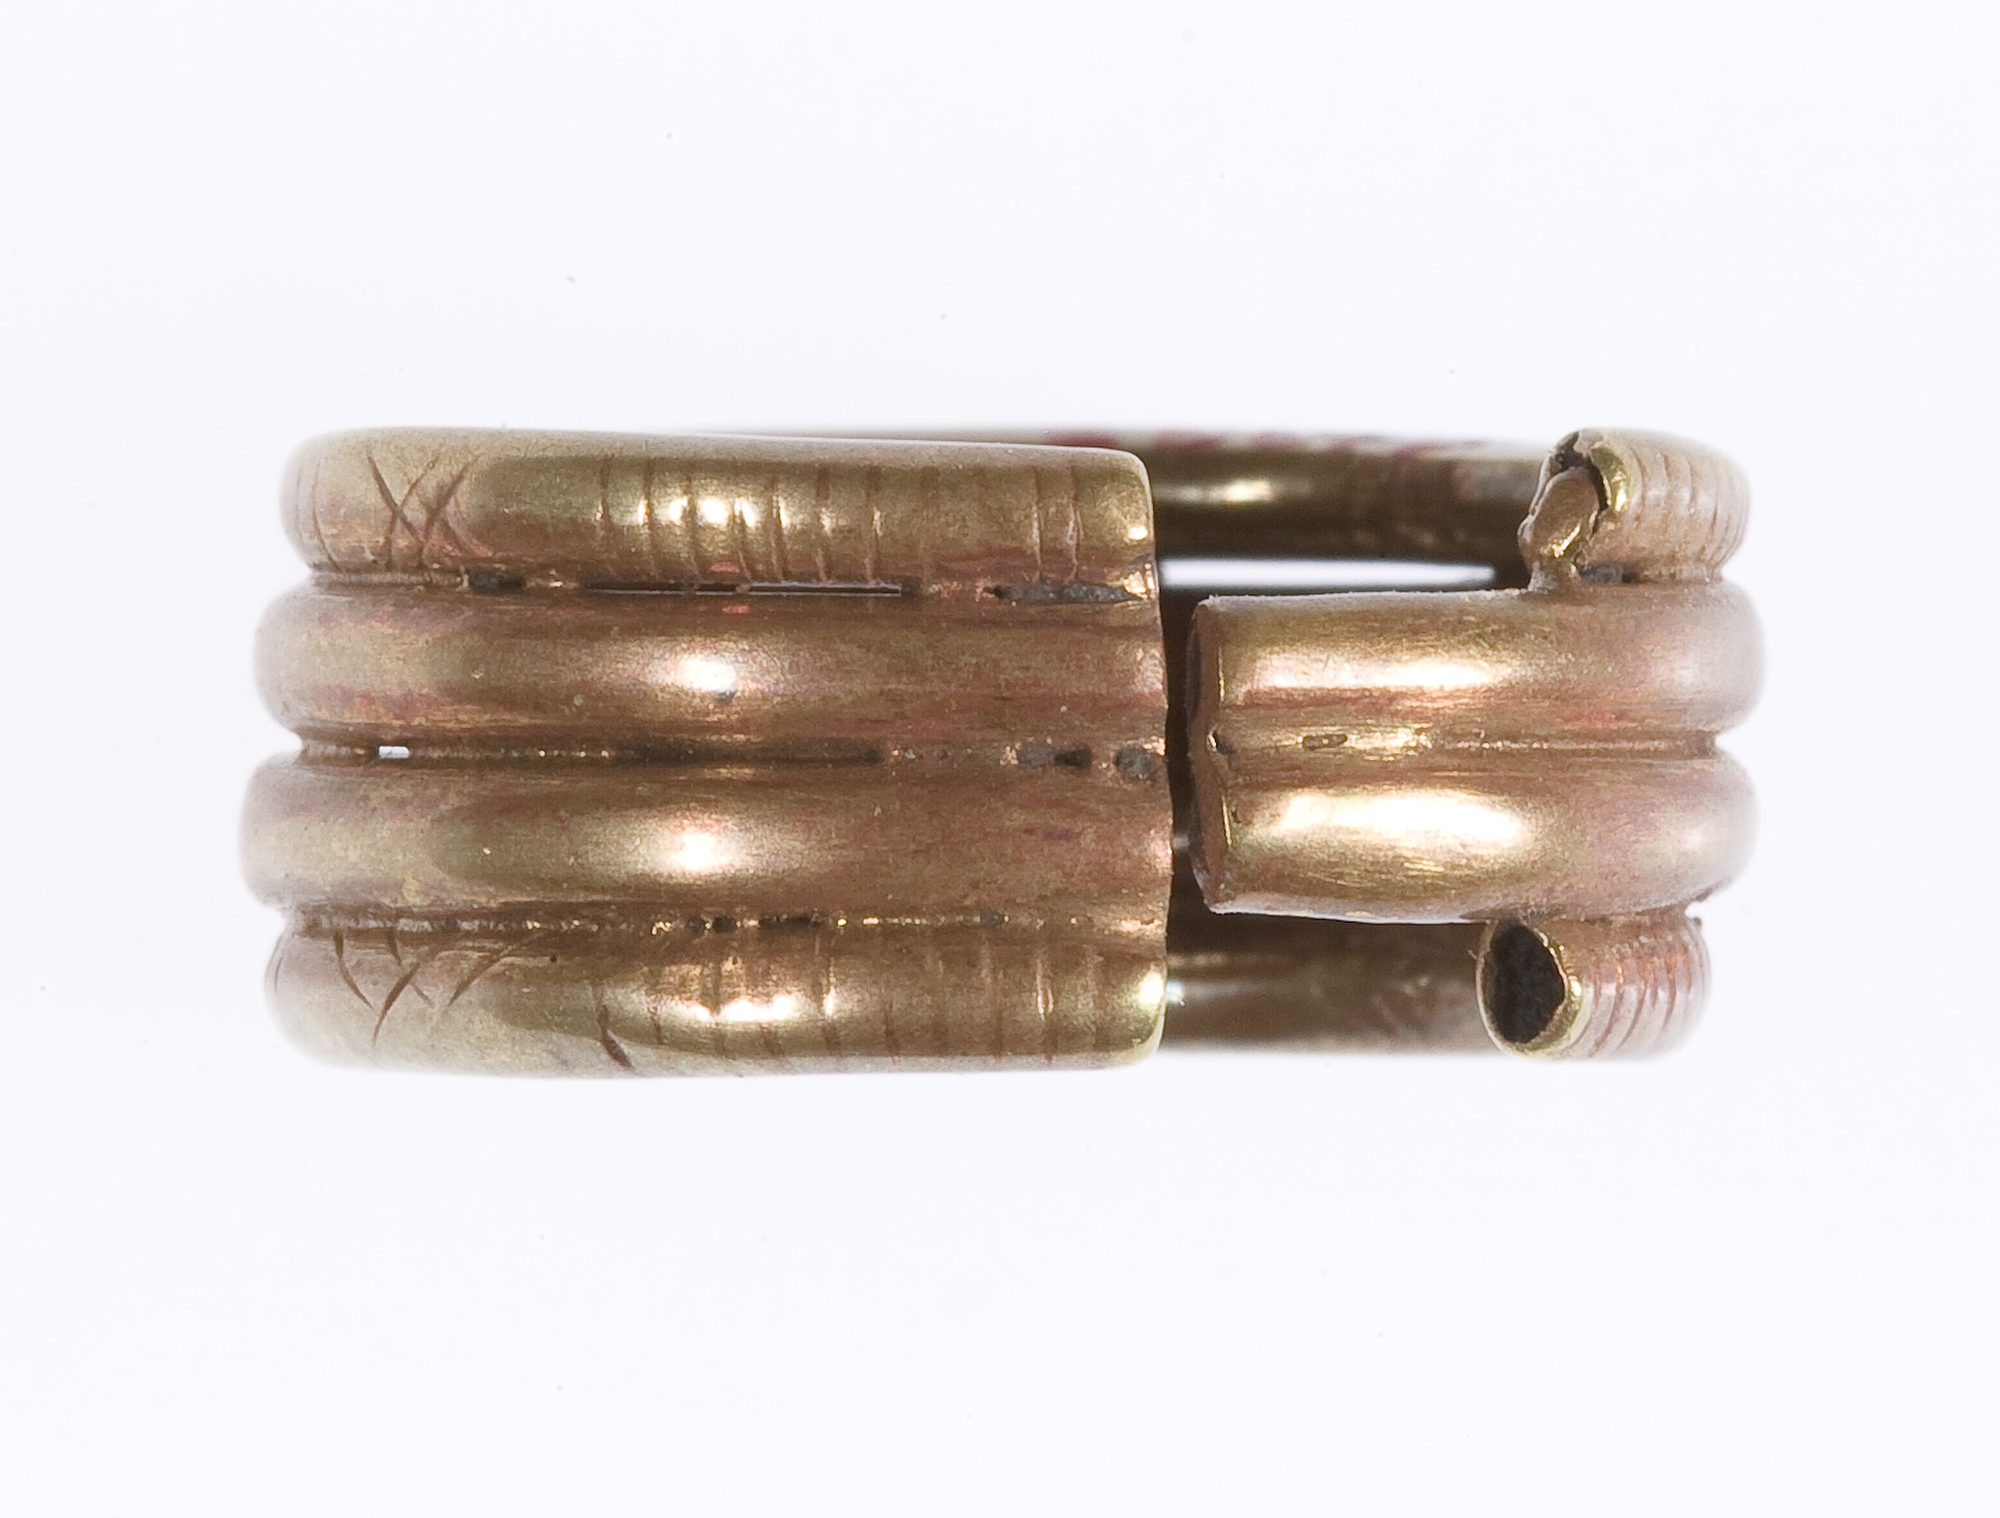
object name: earring, penannular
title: Ribbed Penannular Earring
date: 1991-1450 BCE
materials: gold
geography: egypt